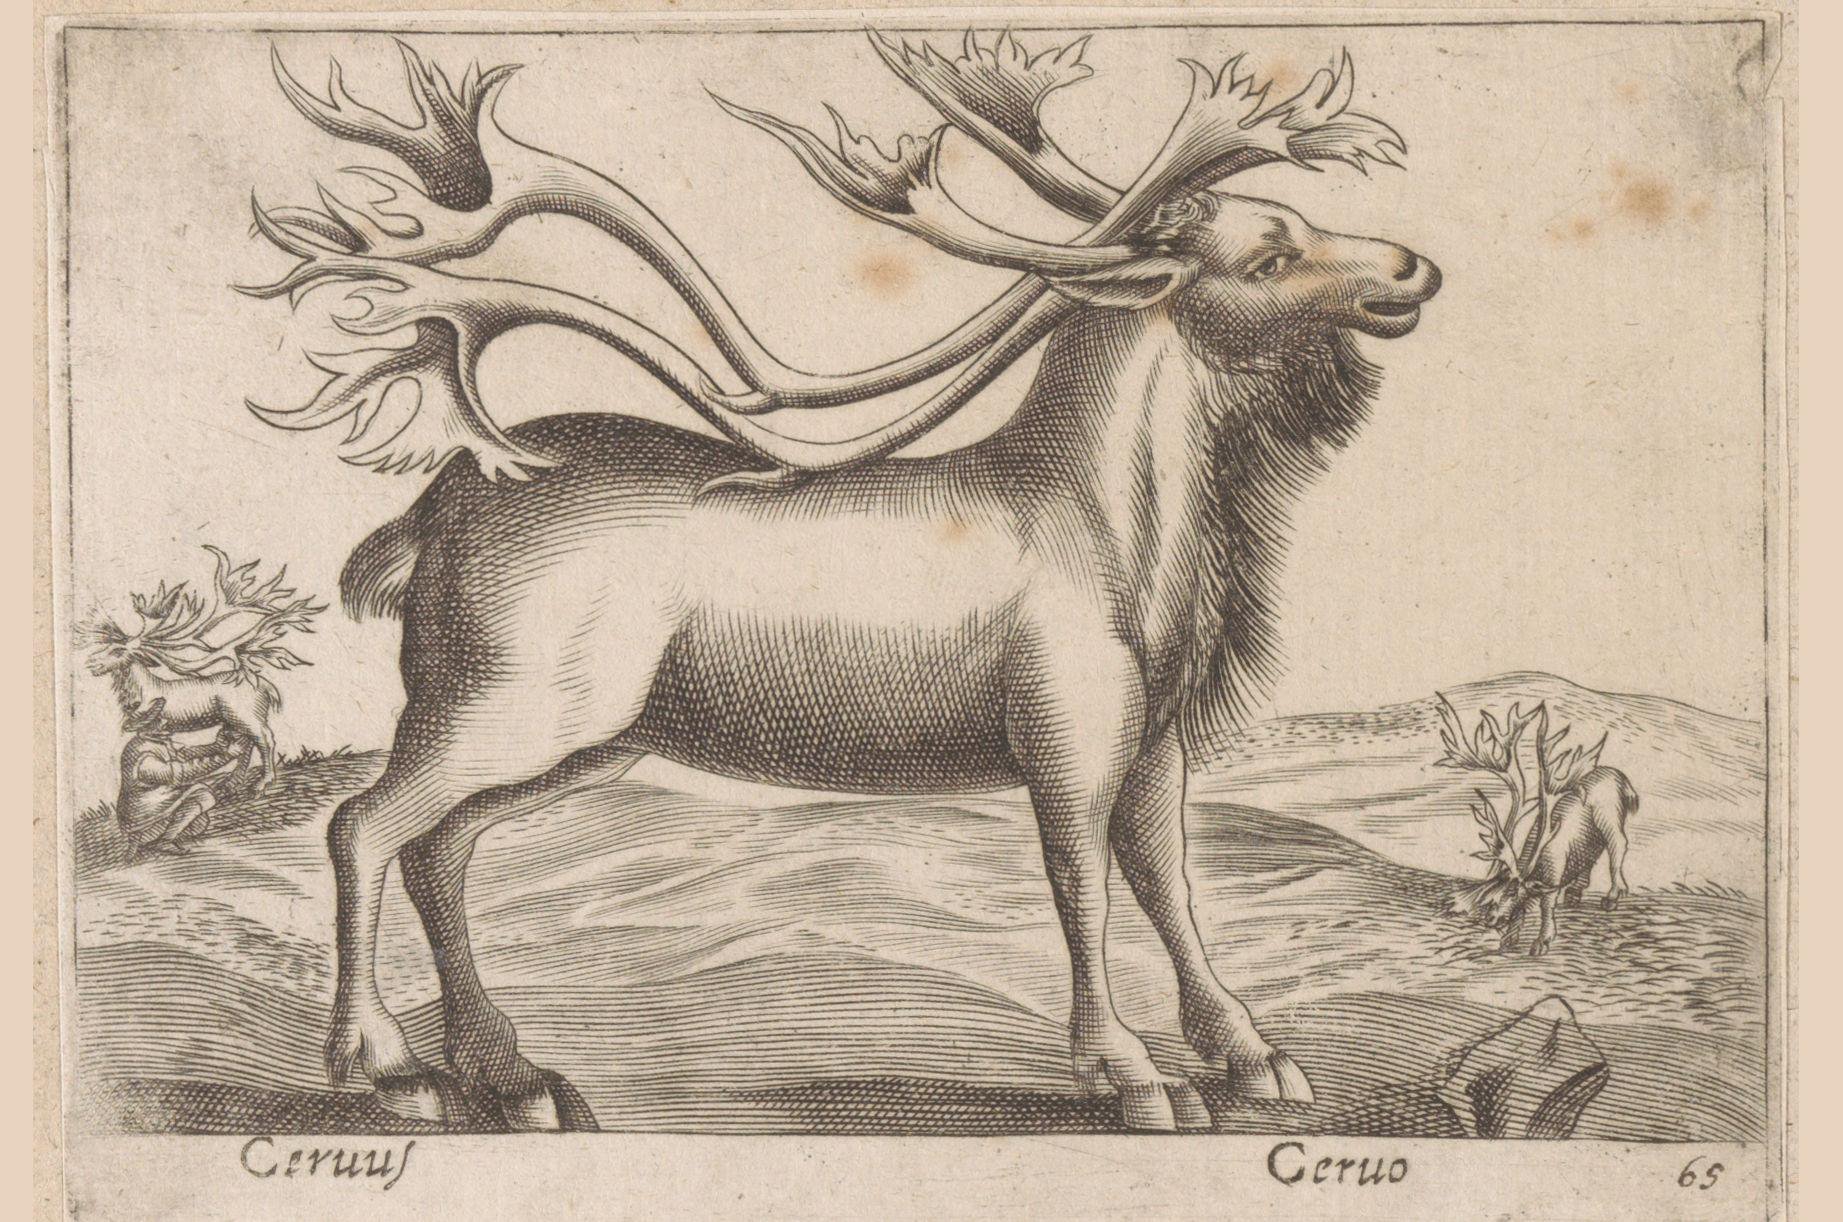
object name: print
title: Nova raccolta de li animali piu curiosi del mondo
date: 1565-1630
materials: paper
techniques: etching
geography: italy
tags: hoofed animals: stag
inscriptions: collector's mark: Lugt 11, number: ‘65’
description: Deze prent maakt deel uit van een reeks prenten van dieren door Antonio Tempesta. Bekend is dat een tweede staat (met nummering) van deze serie is uitgegeven door Giovanni Giacomo de' Rossi in 1650. Onbekend is wie de eerste staat heeft uitgegeven en wanneer.